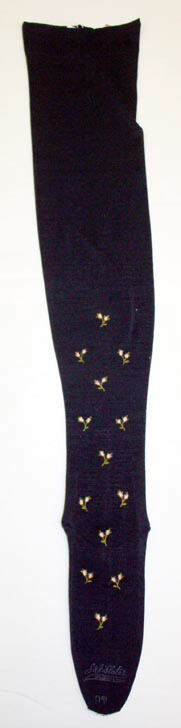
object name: stocking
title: Stockings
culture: american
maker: j. & j. slater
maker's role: designer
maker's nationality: american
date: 1900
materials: silk